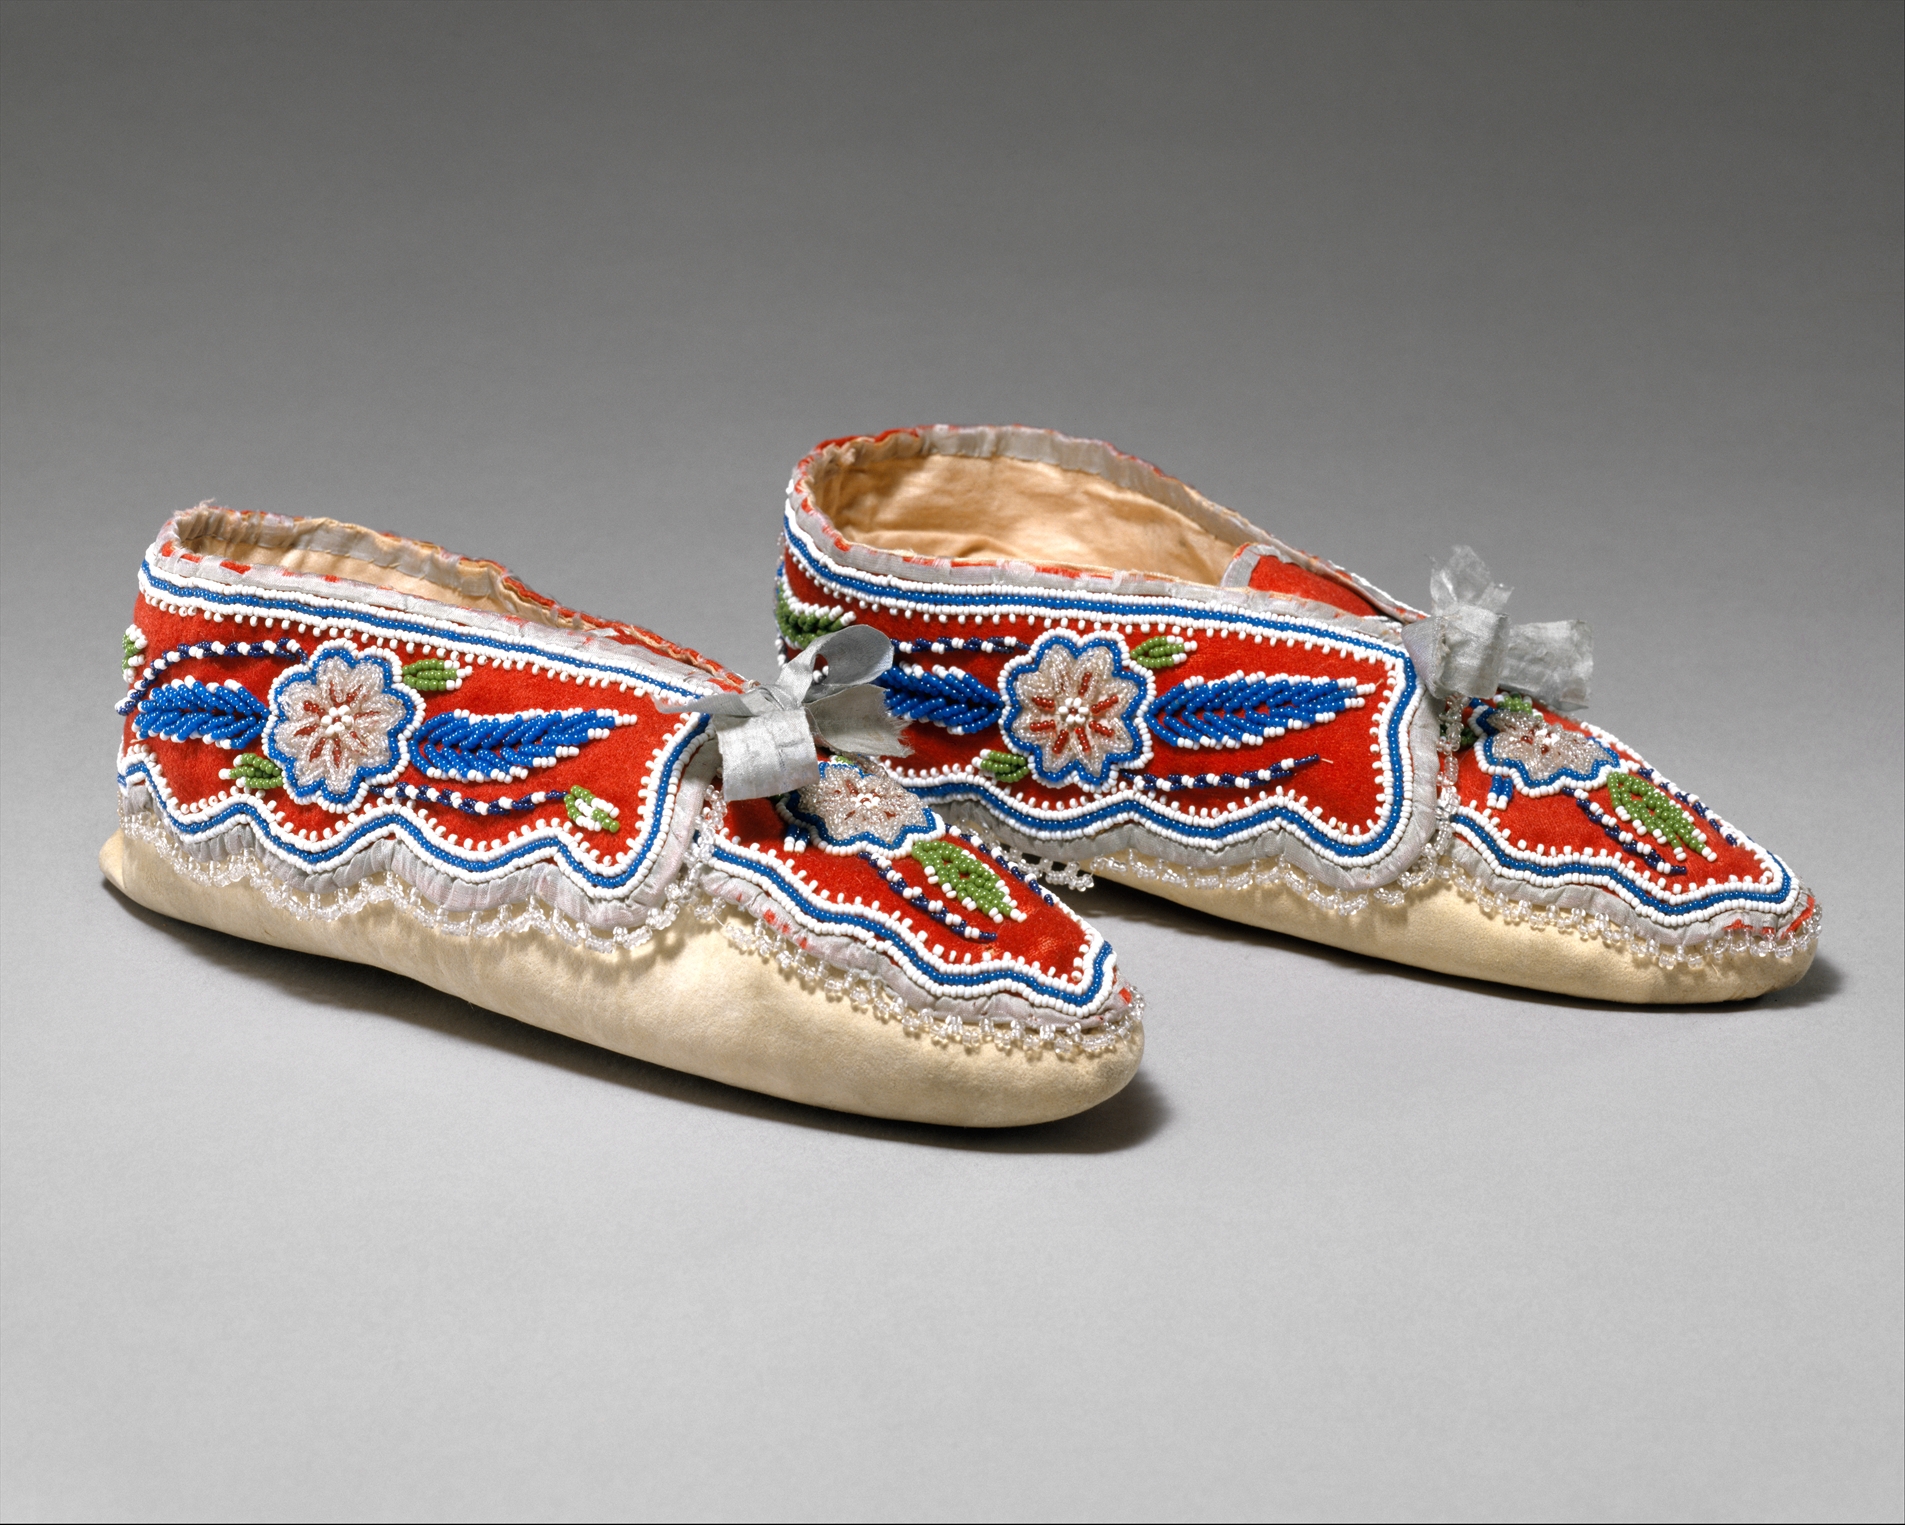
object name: moccasin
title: Pair of Moccasins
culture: huron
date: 1850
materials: cotton, glass, silk, skin, wool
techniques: tanning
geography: canada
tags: shoes,flowers,leaves